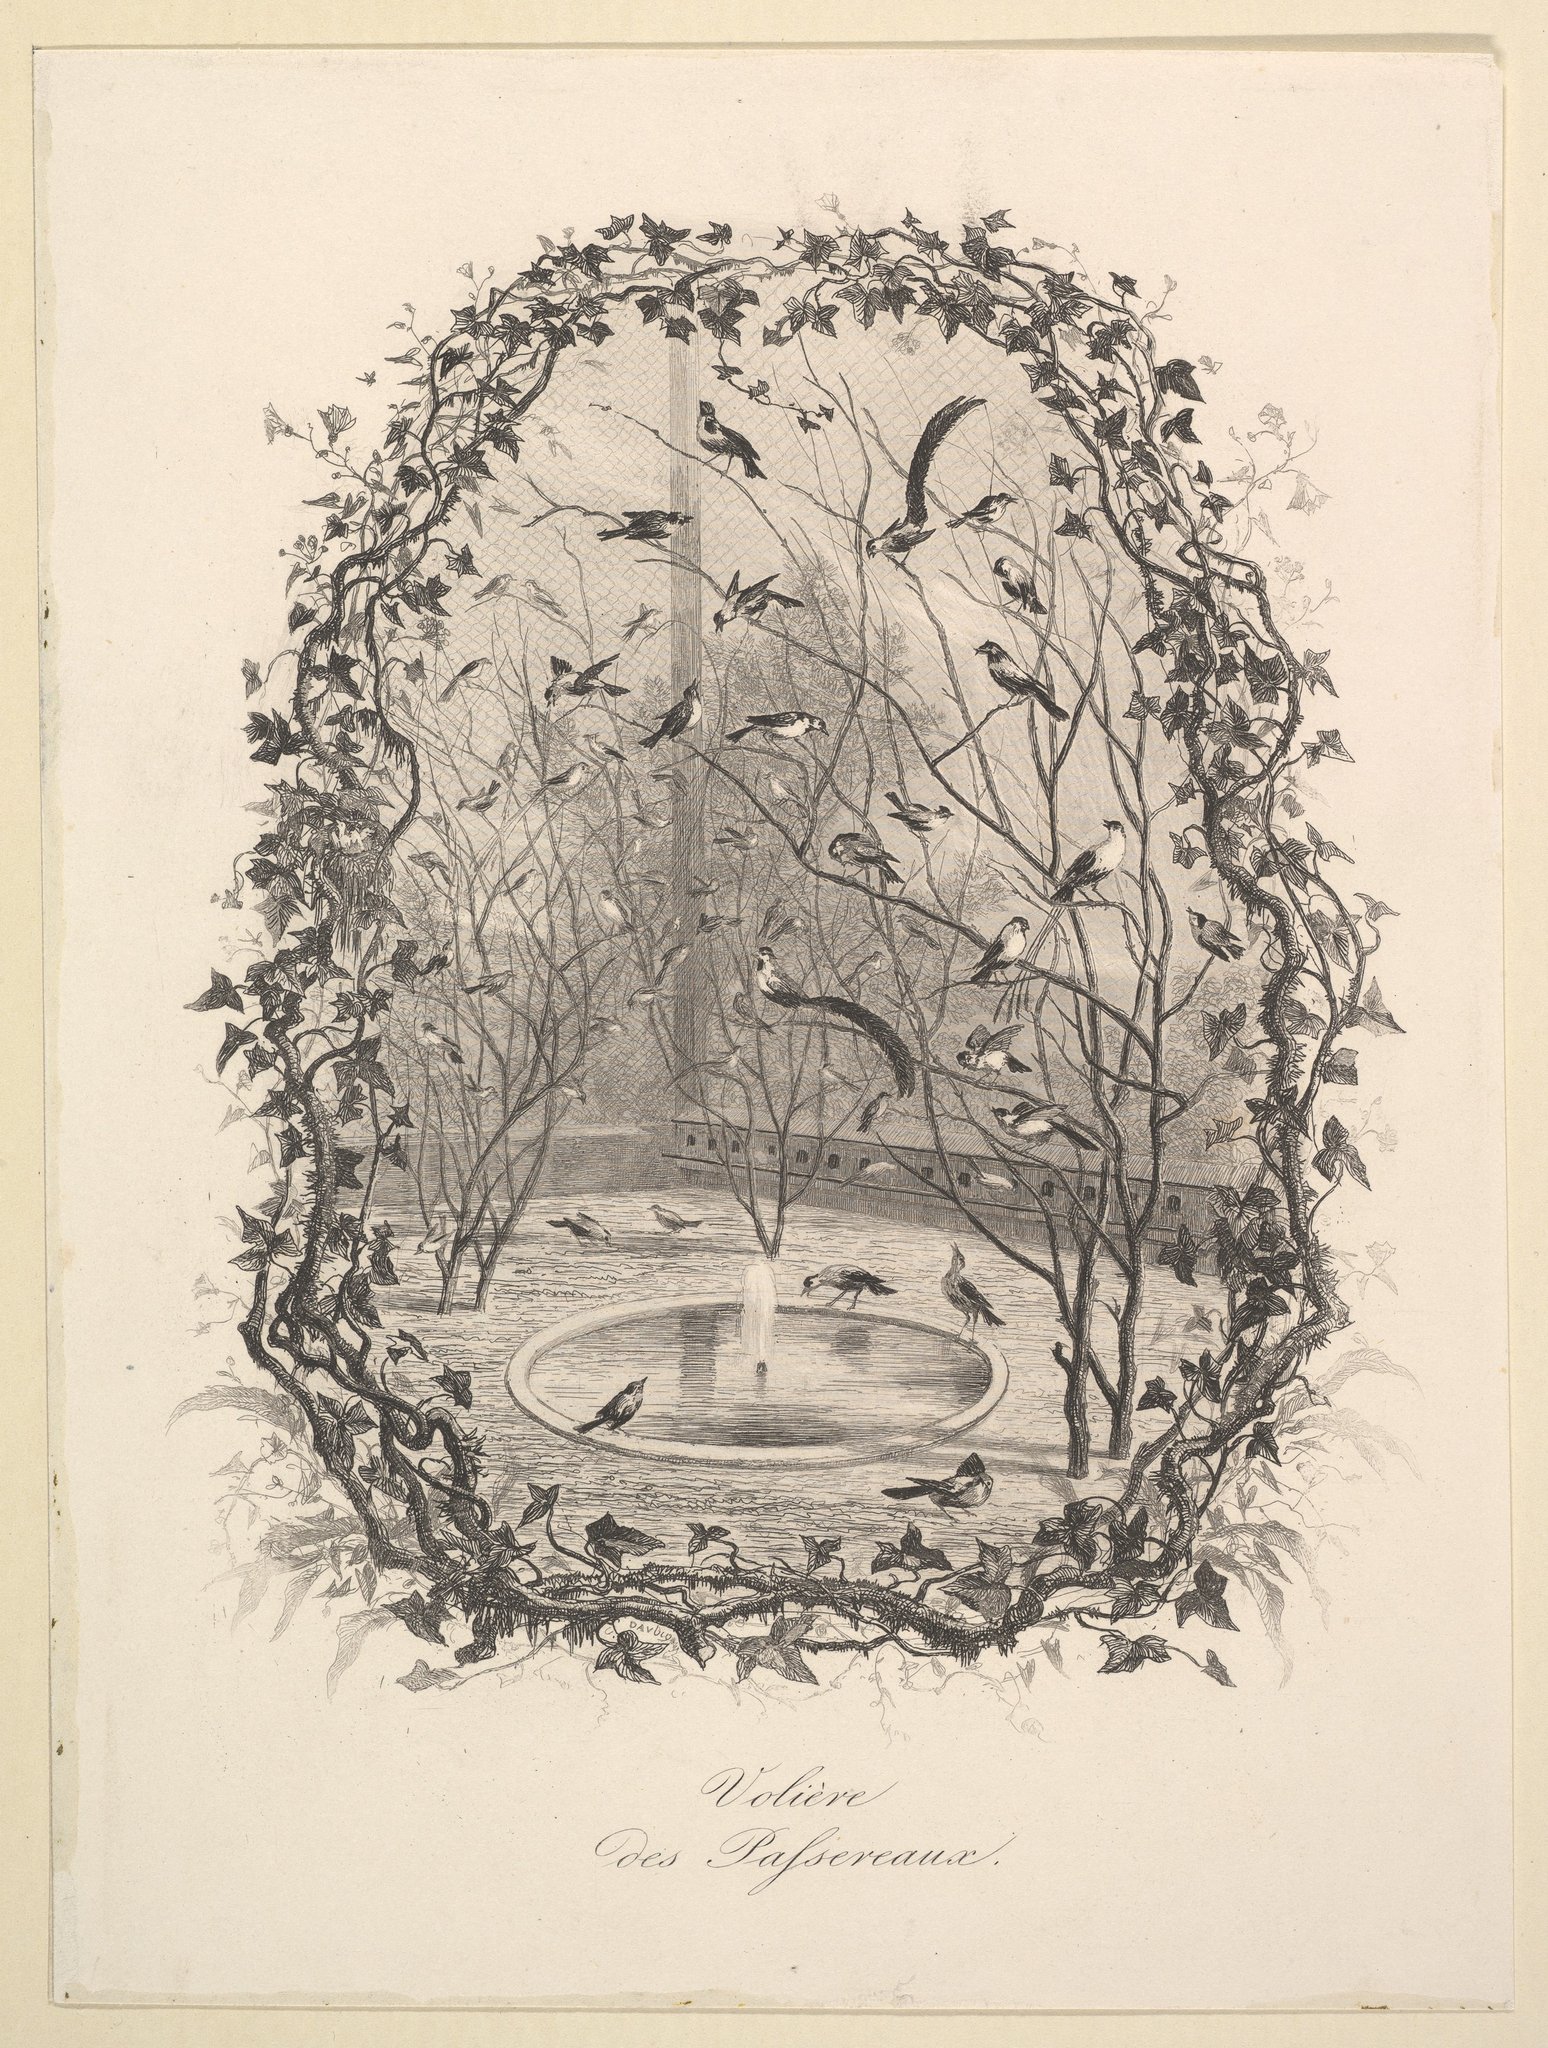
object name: print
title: The Sparrow Aviary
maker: charles-françois daubigny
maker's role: artist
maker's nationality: french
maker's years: 1817-1878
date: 1843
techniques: etching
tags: birds,fountains,leaves